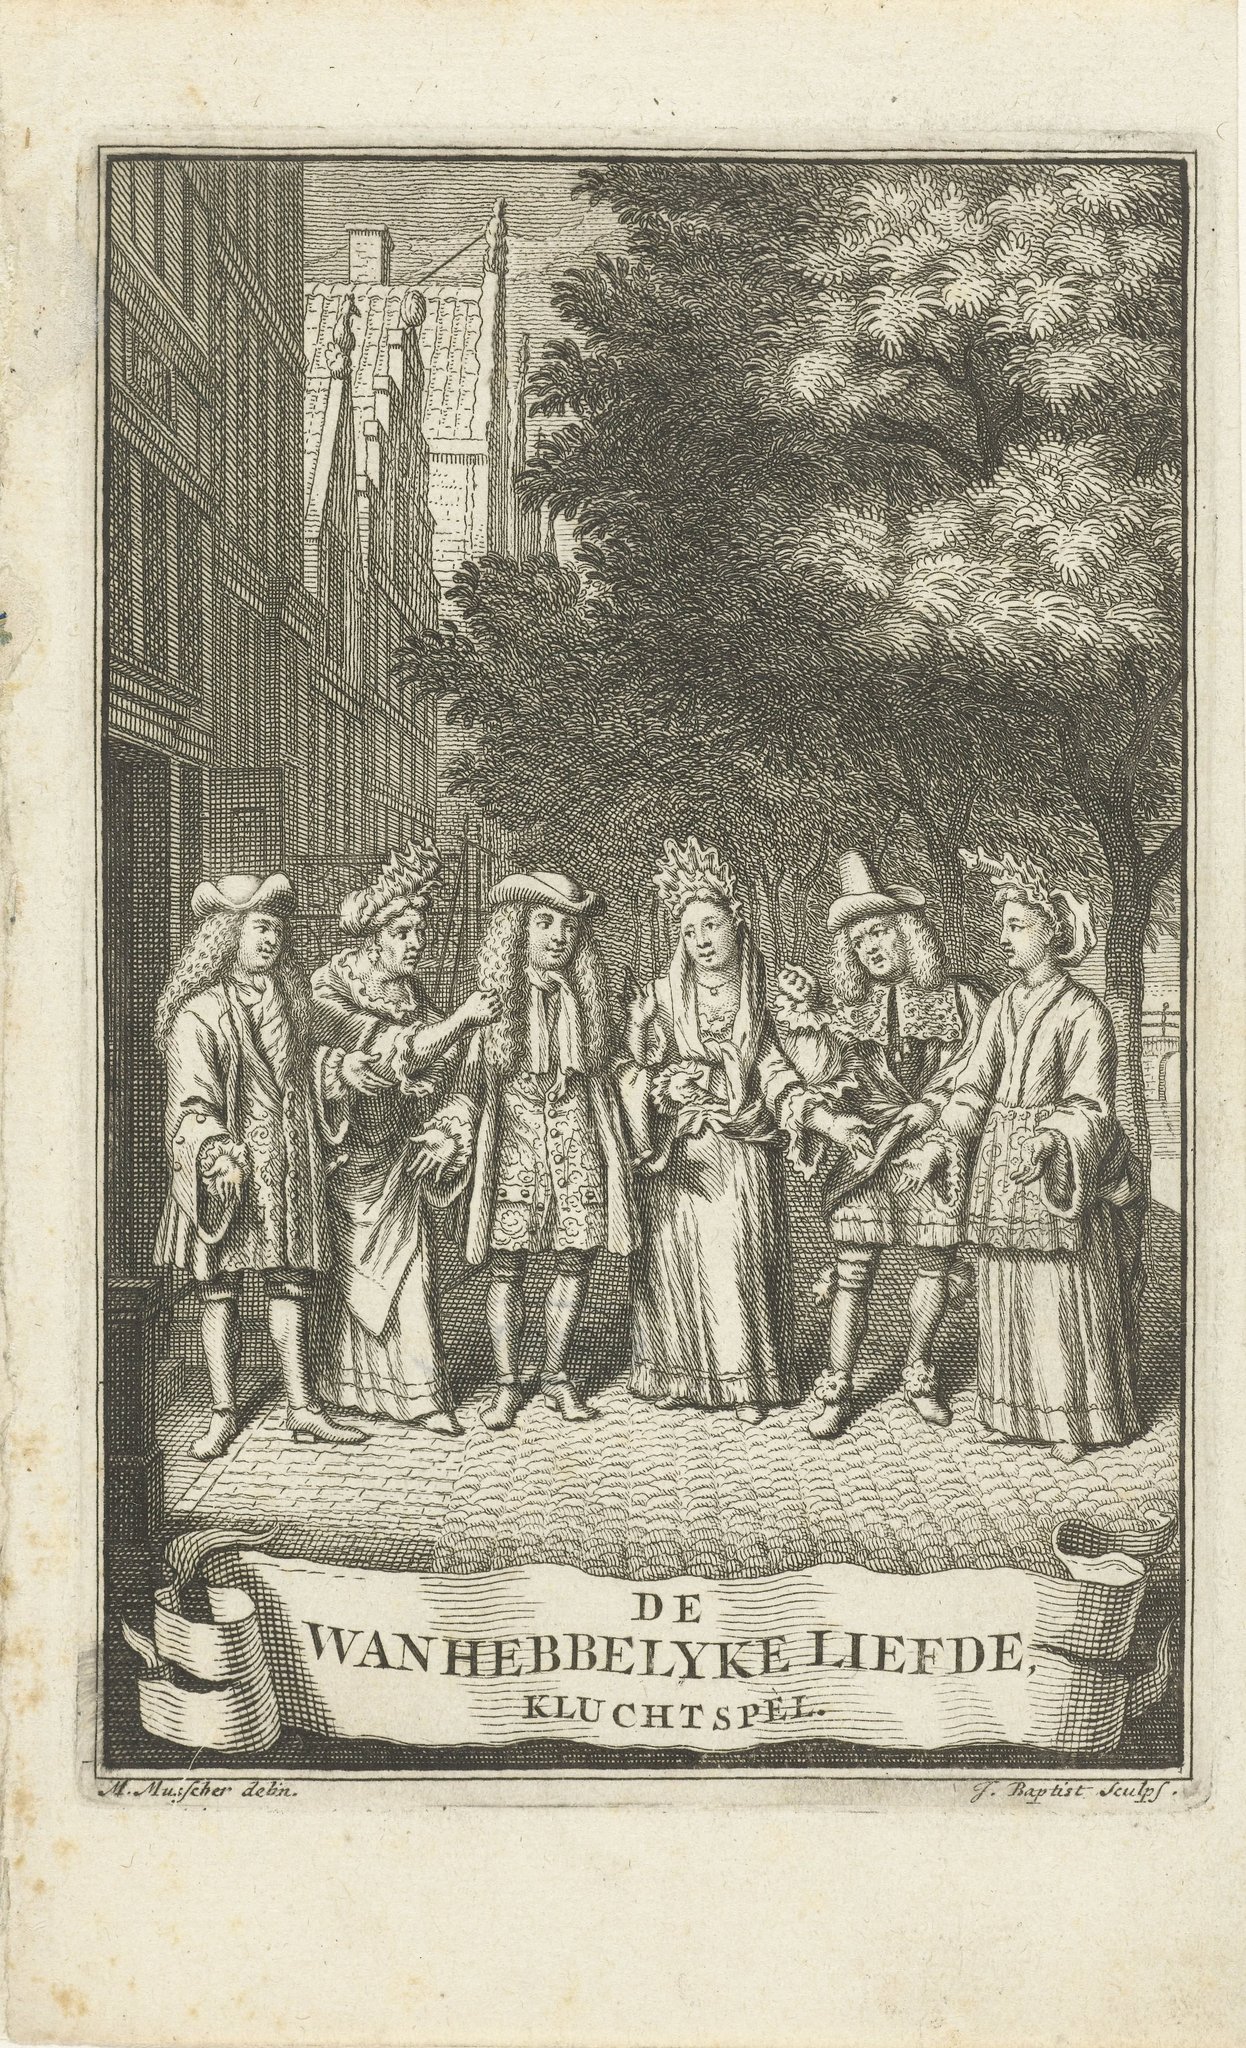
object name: print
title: Titelpagina voor De wanhebbelyke liefde, kluchtspel, Amsterdam 1704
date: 1704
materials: paper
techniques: engraving, etching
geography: amsterdam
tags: group of actors, troupe; actors on the stage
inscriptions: collector's mark: Lugt 2228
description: De zes toneelspelers die de hoofdrollen spelen in de klucht De wanhebbelyke liefde, op een gracht in Amsterdam.